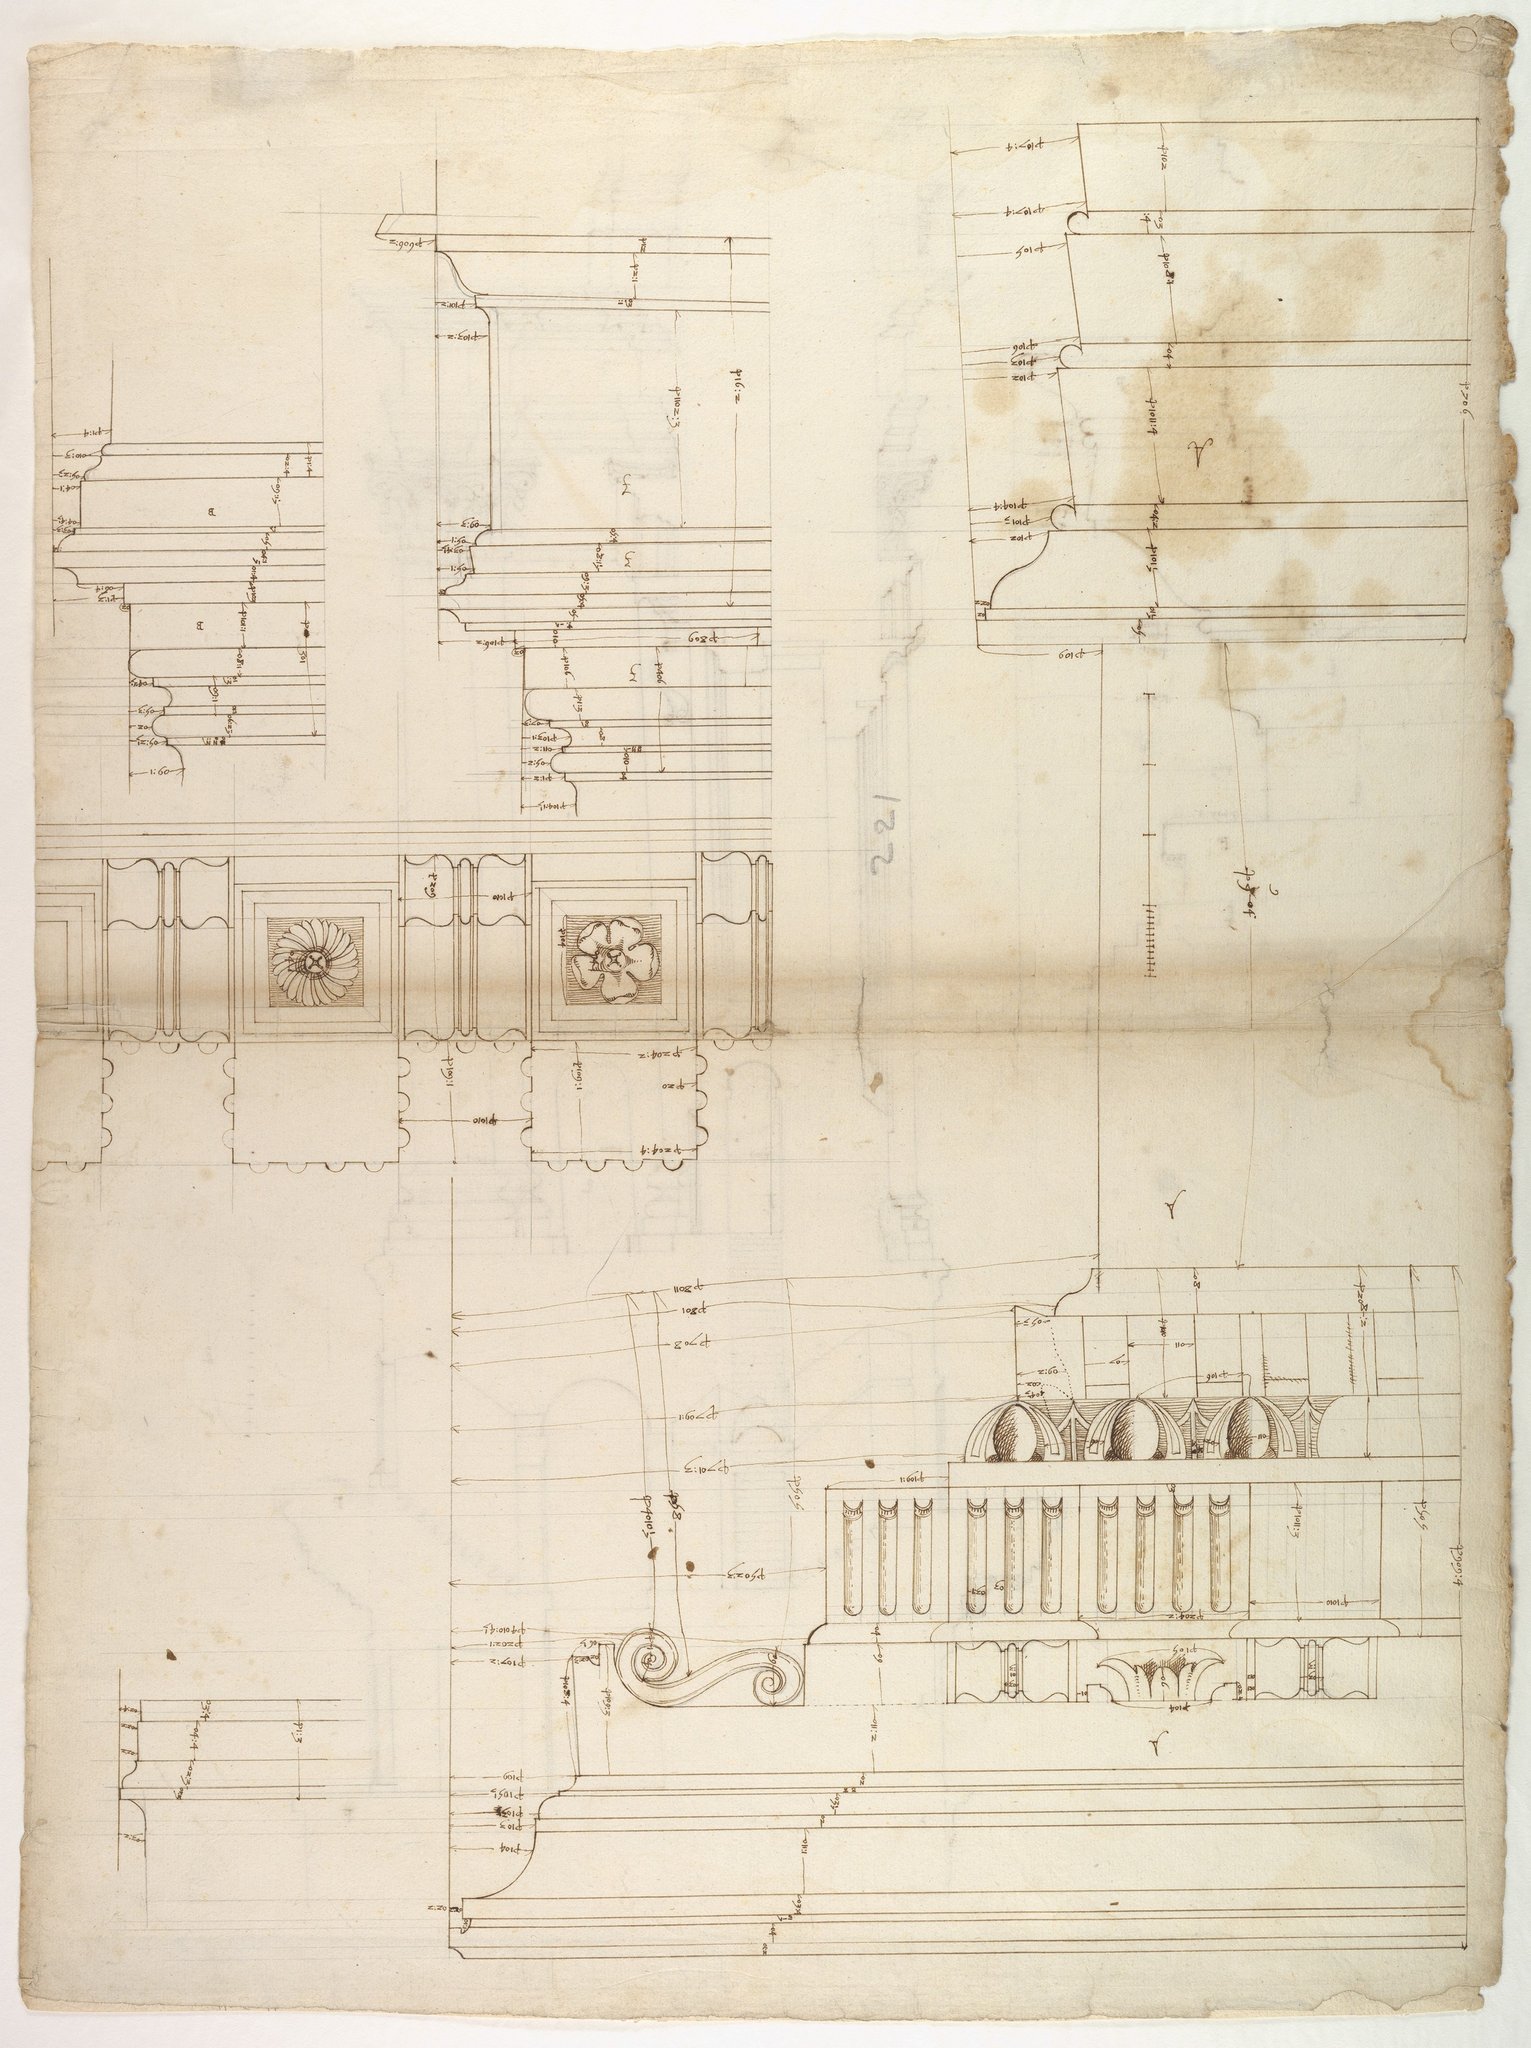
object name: drawing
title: St Peter's, entablature profile; reflected ceiling details of the cornice, and profiles of column bases and pedestals (recto) St. Peter's, section through drum of model and entablature of upper story (verso)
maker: anonymous, french, 16th century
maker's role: draftsman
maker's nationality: french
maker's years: 1500-1600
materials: chalk, ink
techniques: incising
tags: architecture